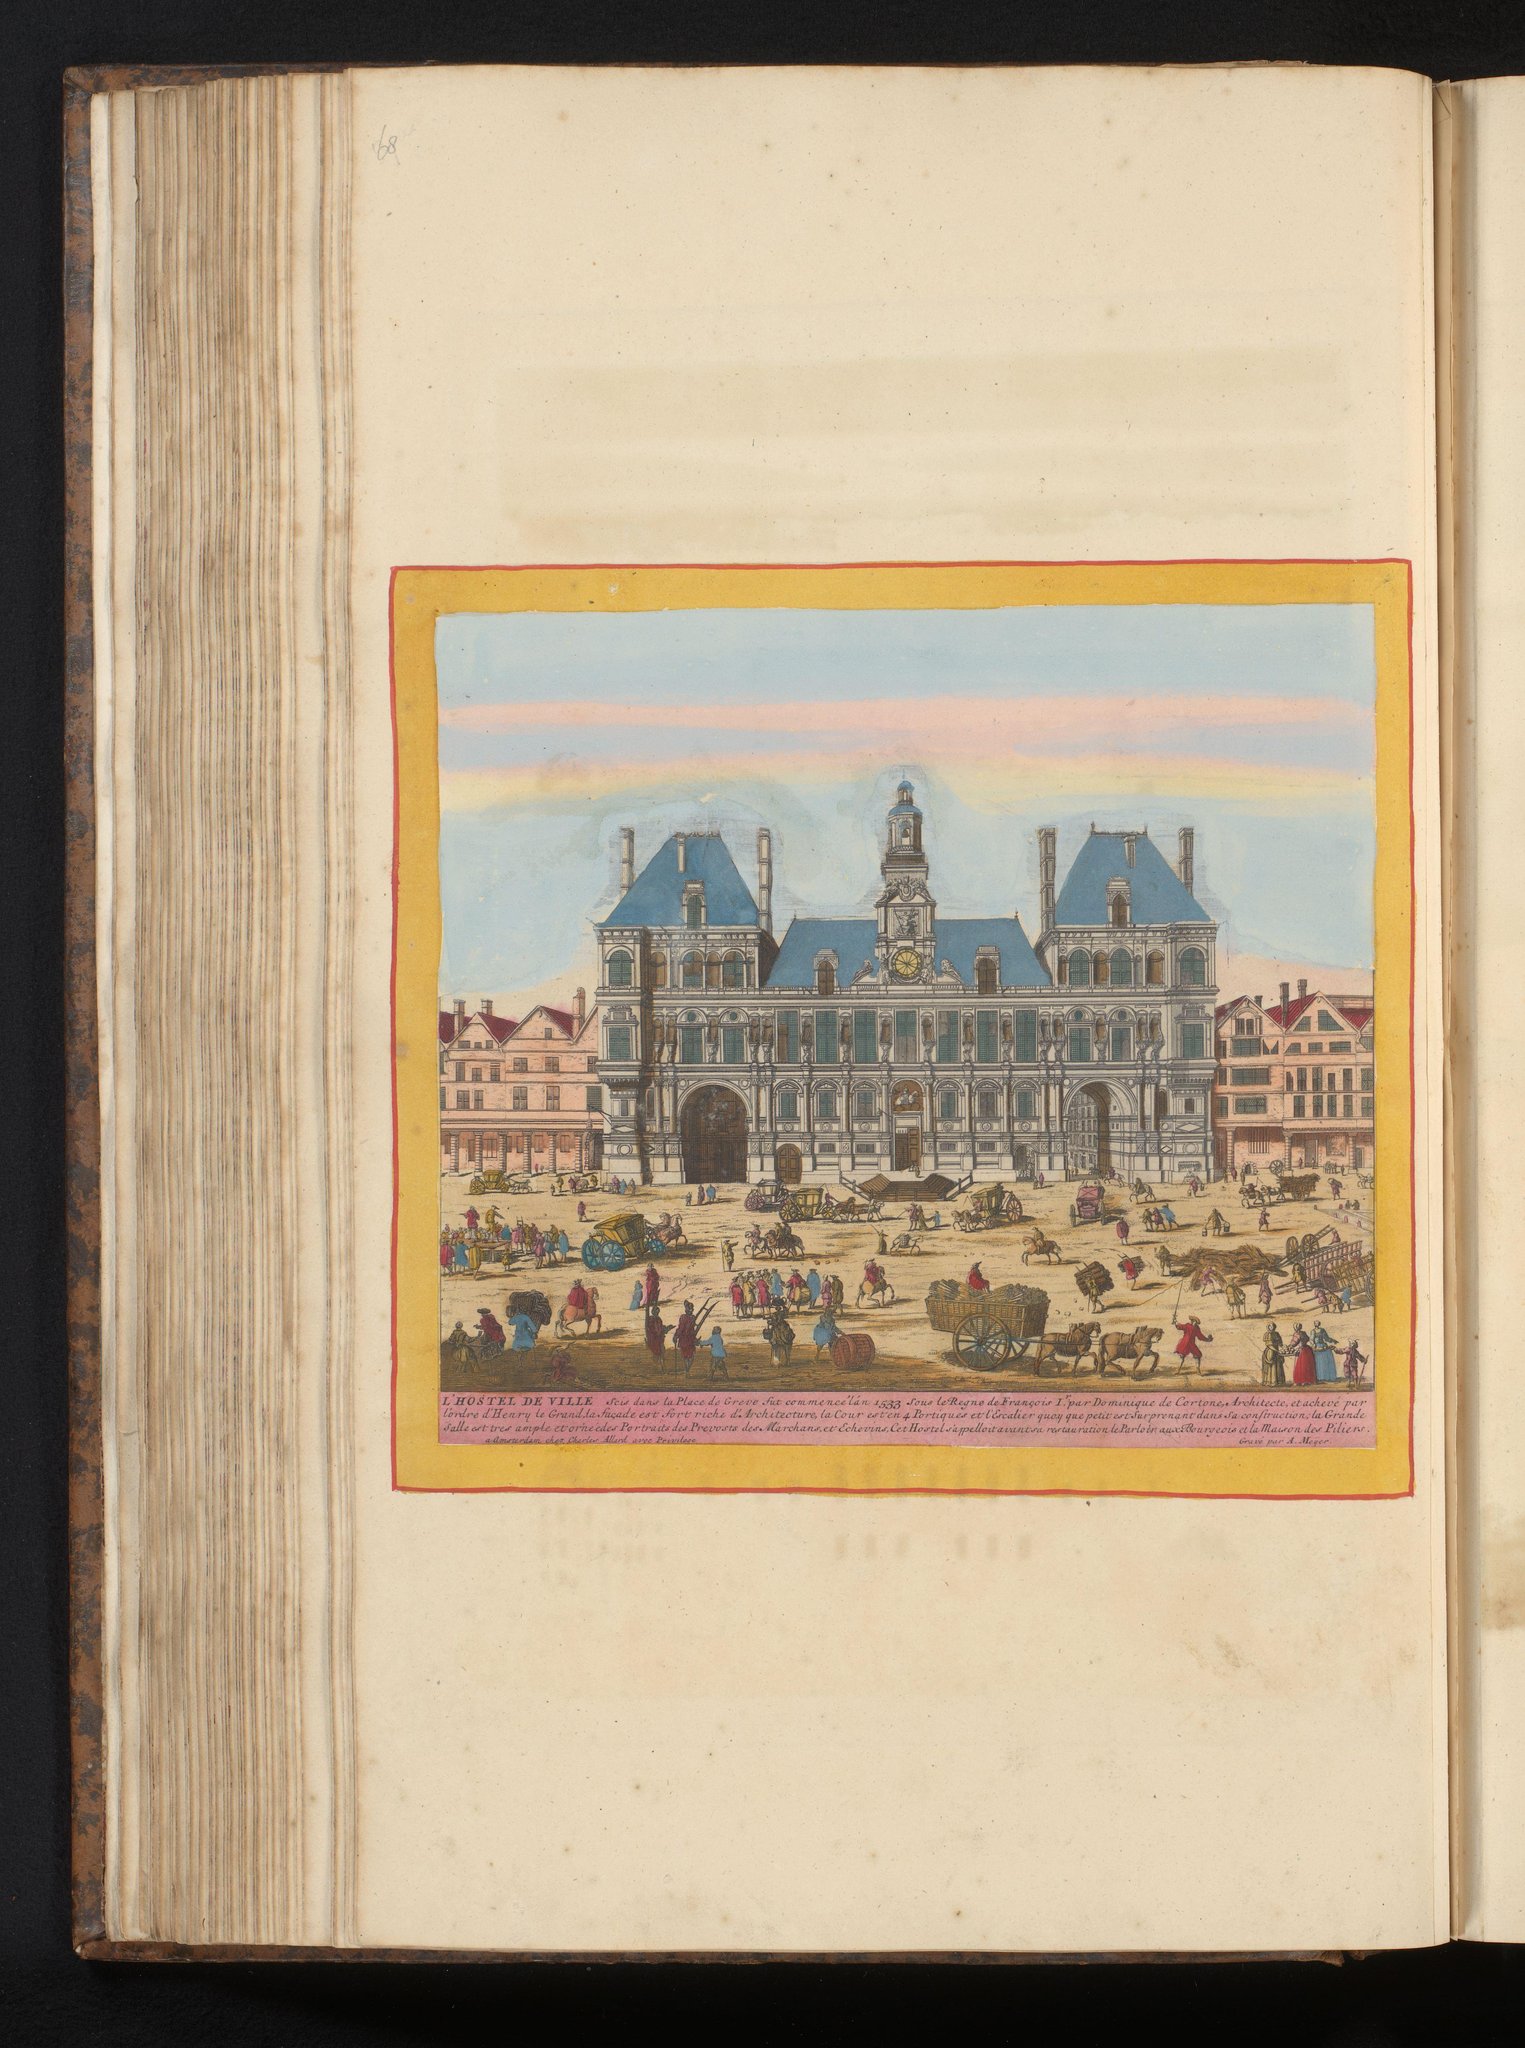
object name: album leaf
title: Stadhuis van Parijs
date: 1685-1695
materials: paper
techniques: engraving, etching, hand coloring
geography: northern netherlands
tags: townhall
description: De prent is langs de bovenrand van de voorstelling afgescheurd. De voorstelling is aan de bovenzijde aangevuld met een geschilderde lucht.